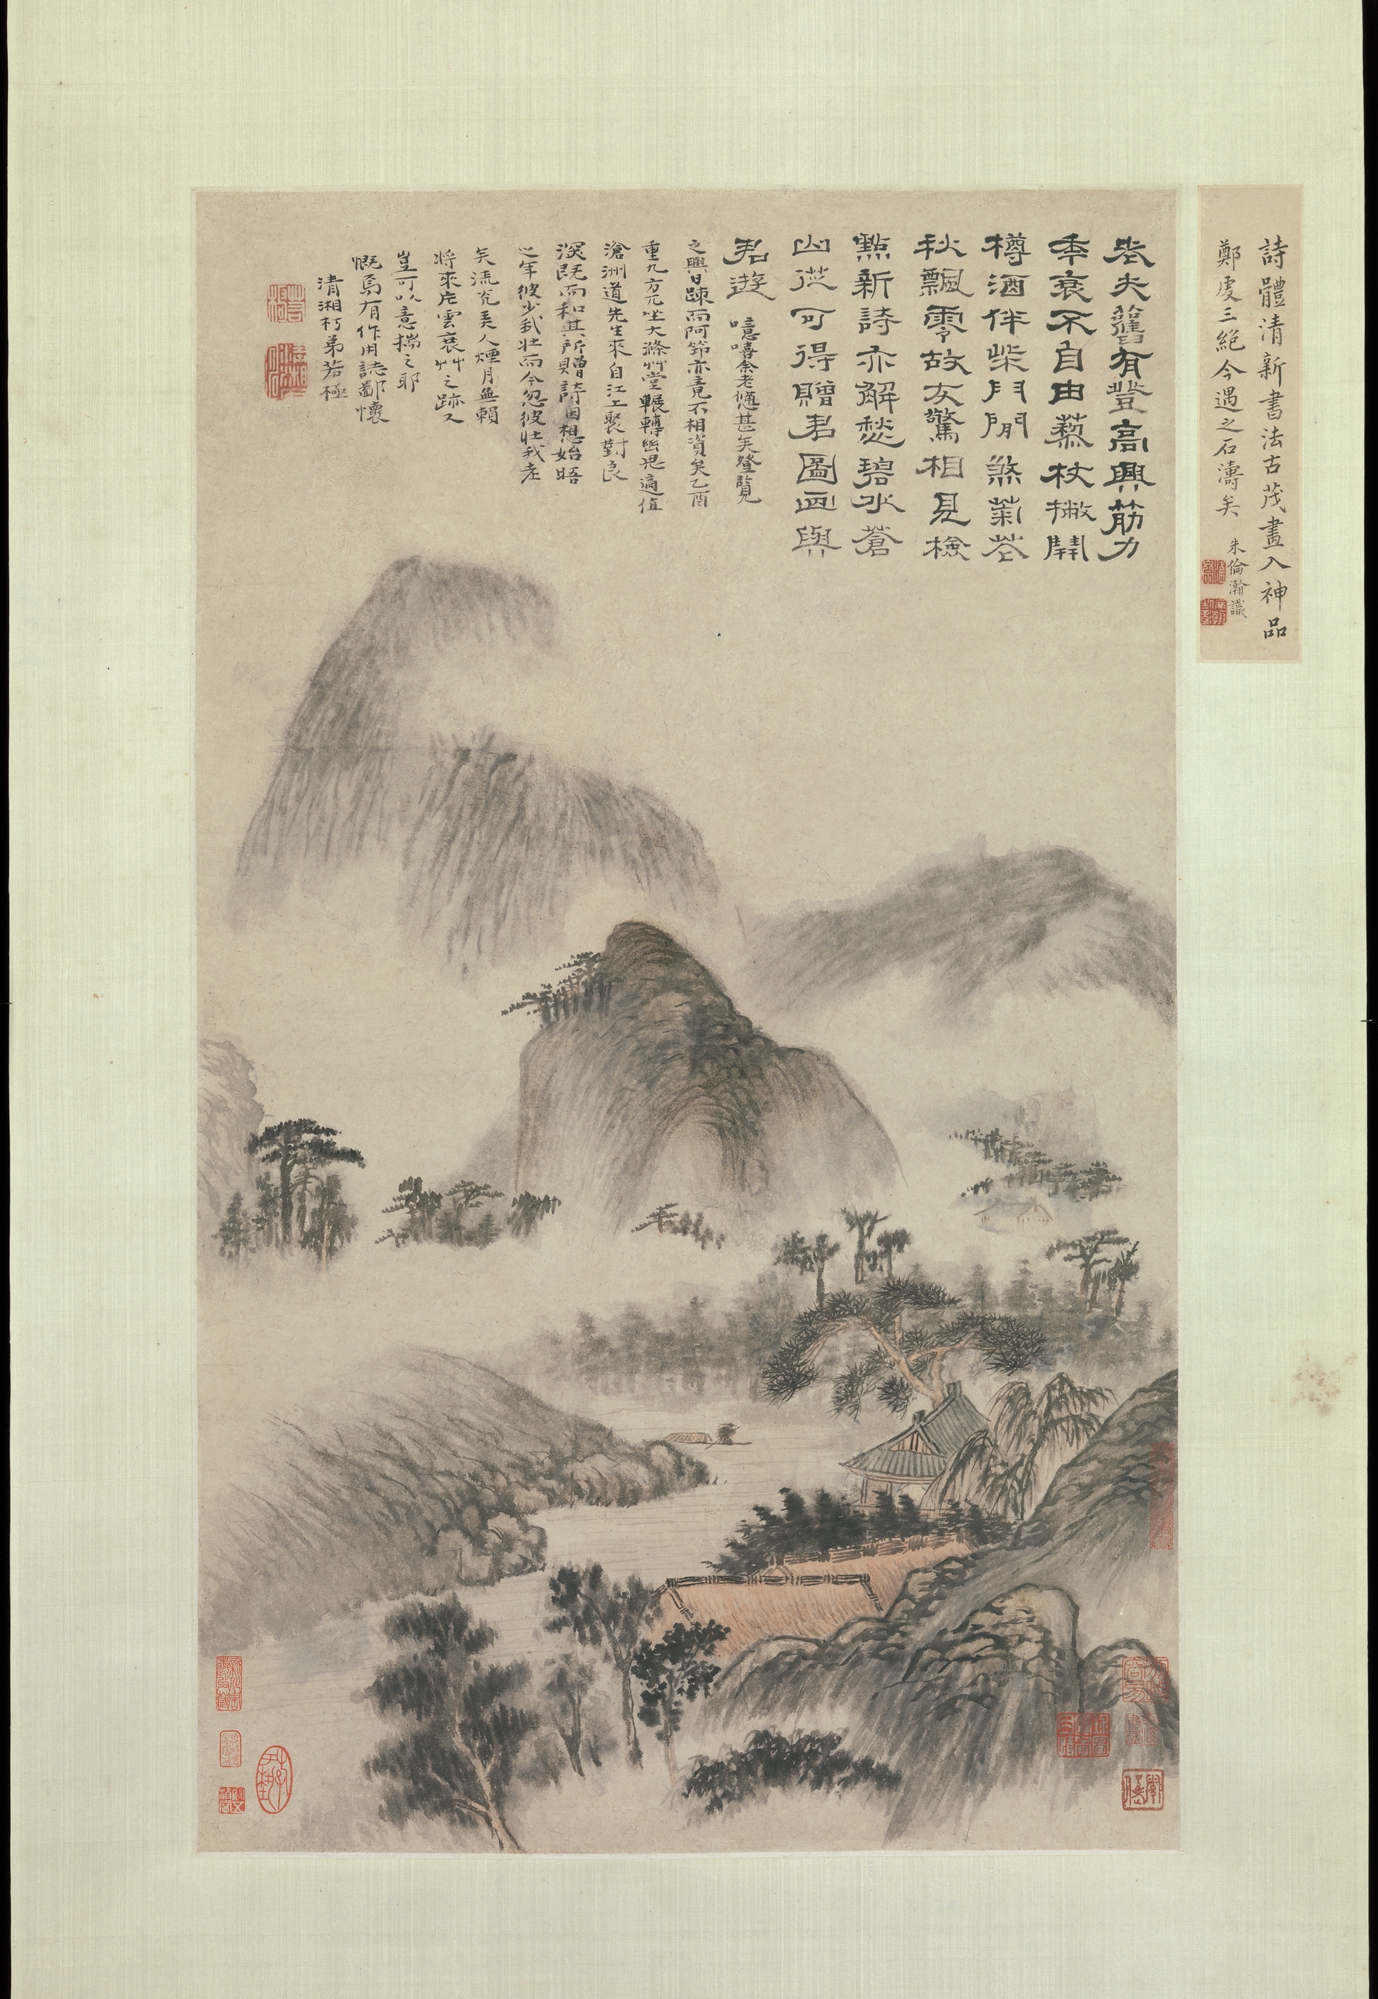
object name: hanging scroll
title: Landscape Painted on the Double Ninth Festival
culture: chinese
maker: shitao (zhu ruoji)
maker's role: artist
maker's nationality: chinese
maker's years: 1642-1707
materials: ink, paper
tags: mountains,landscapes